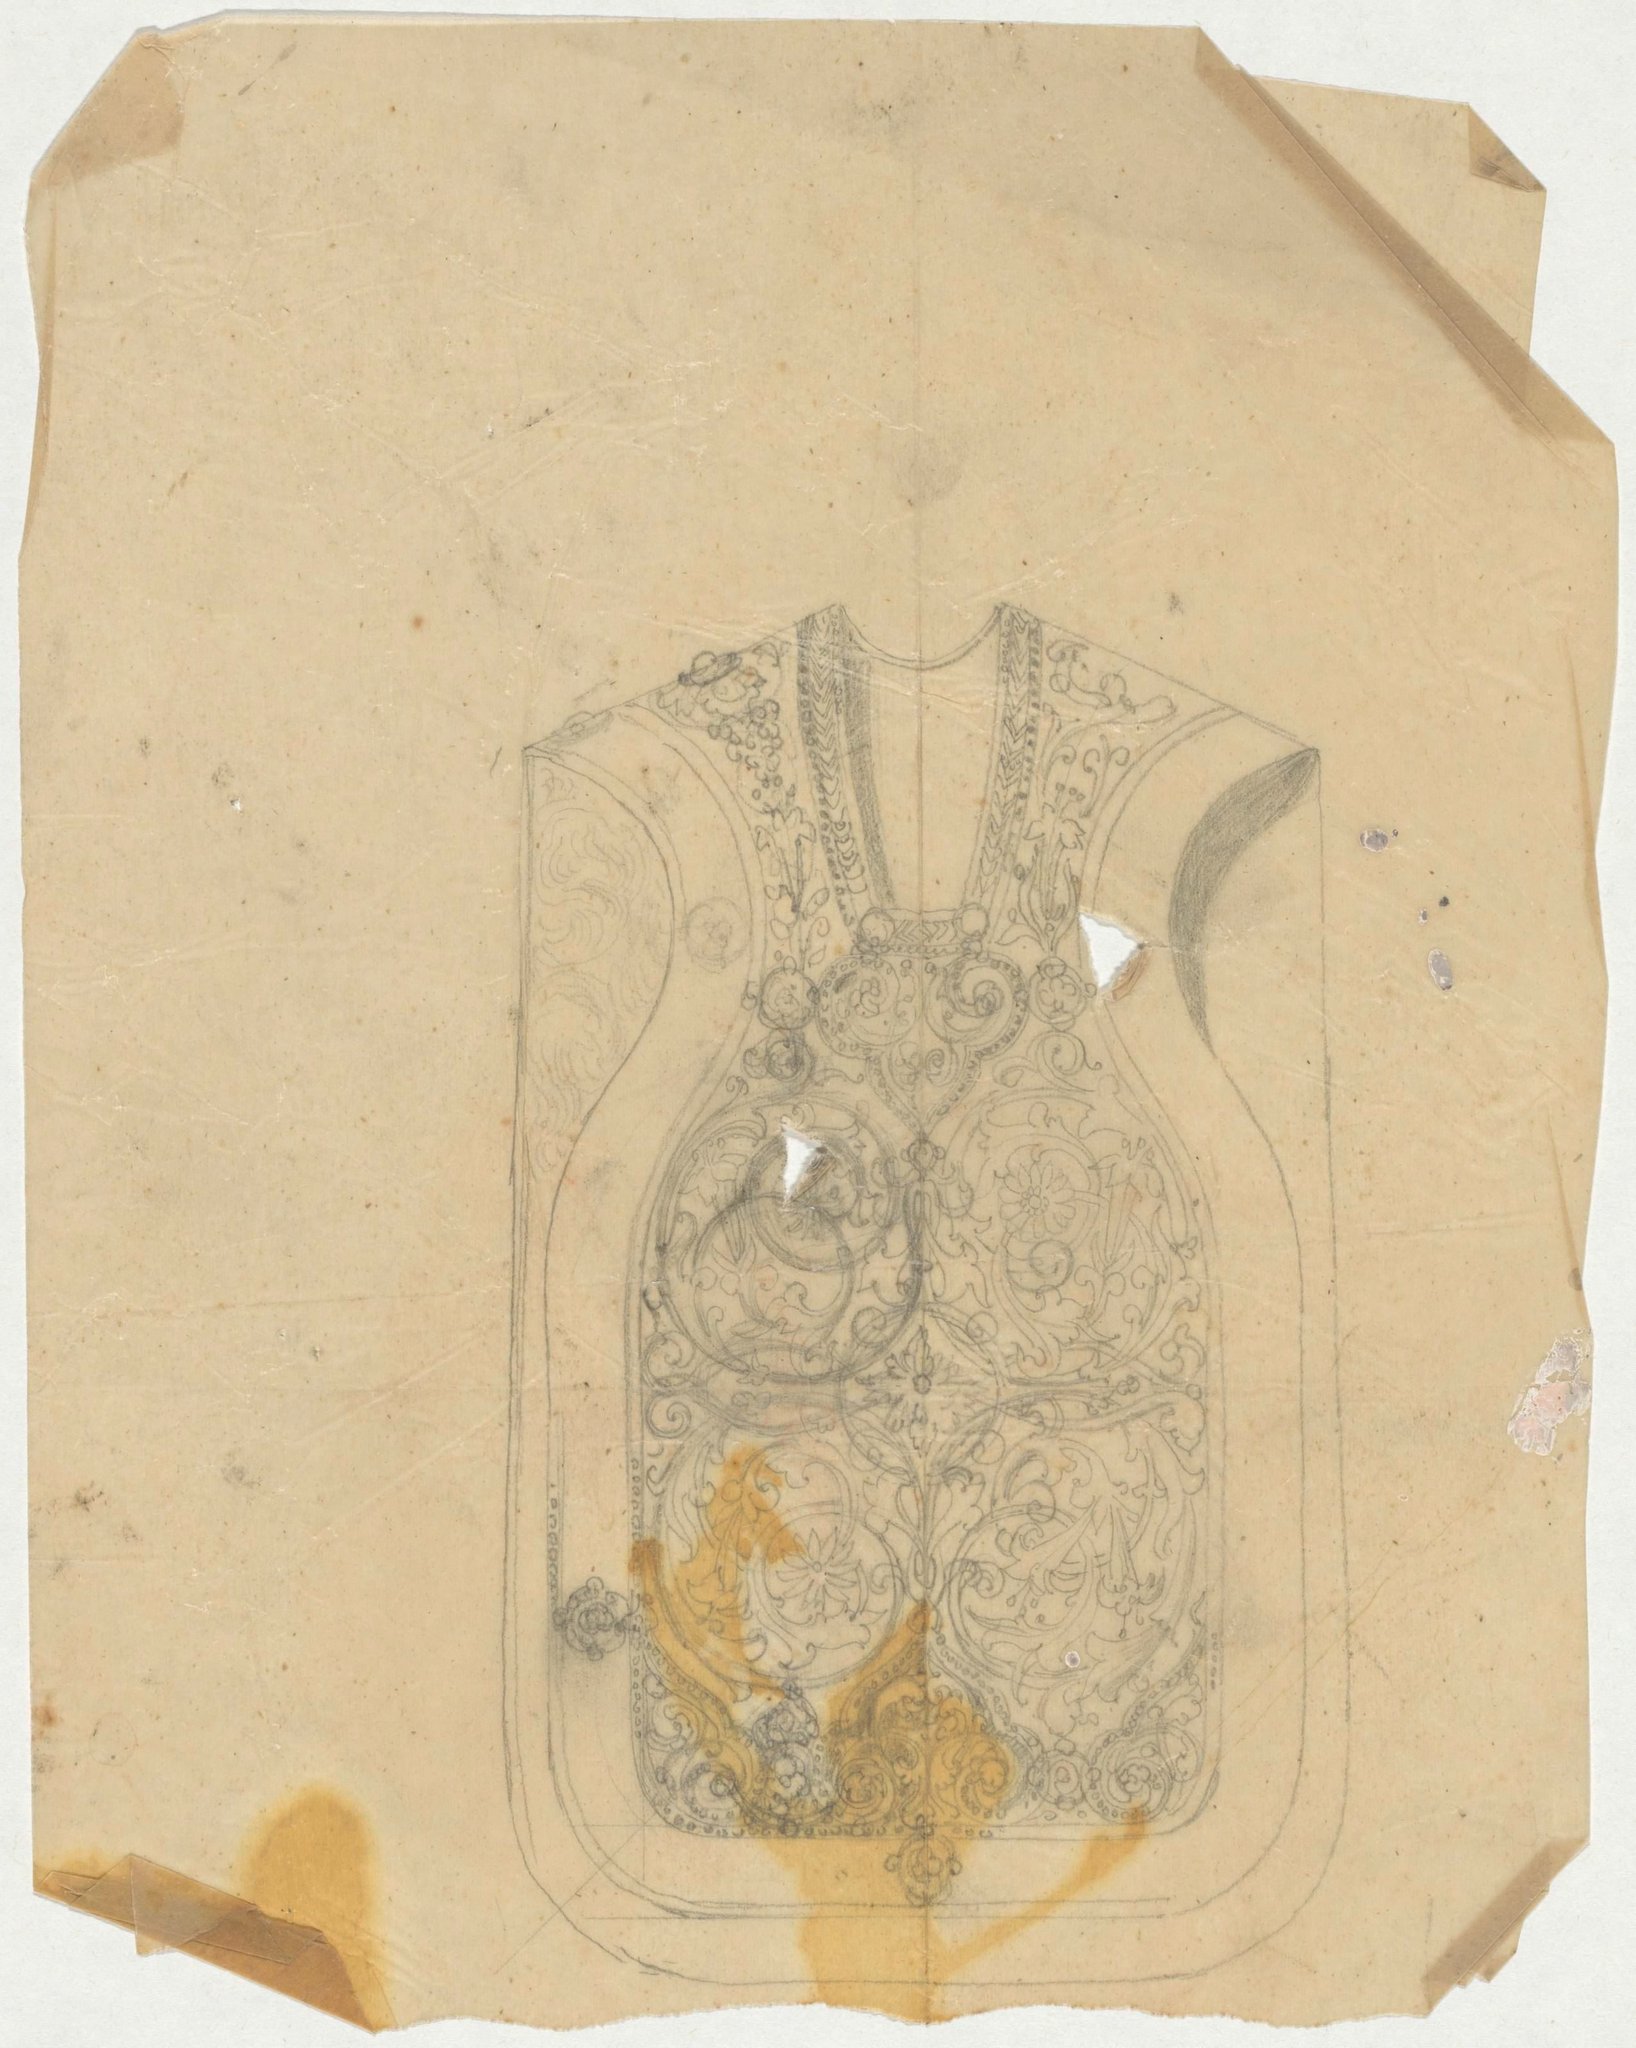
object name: design drawing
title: Kazuifel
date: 1830-1850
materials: graphite, paper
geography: paris